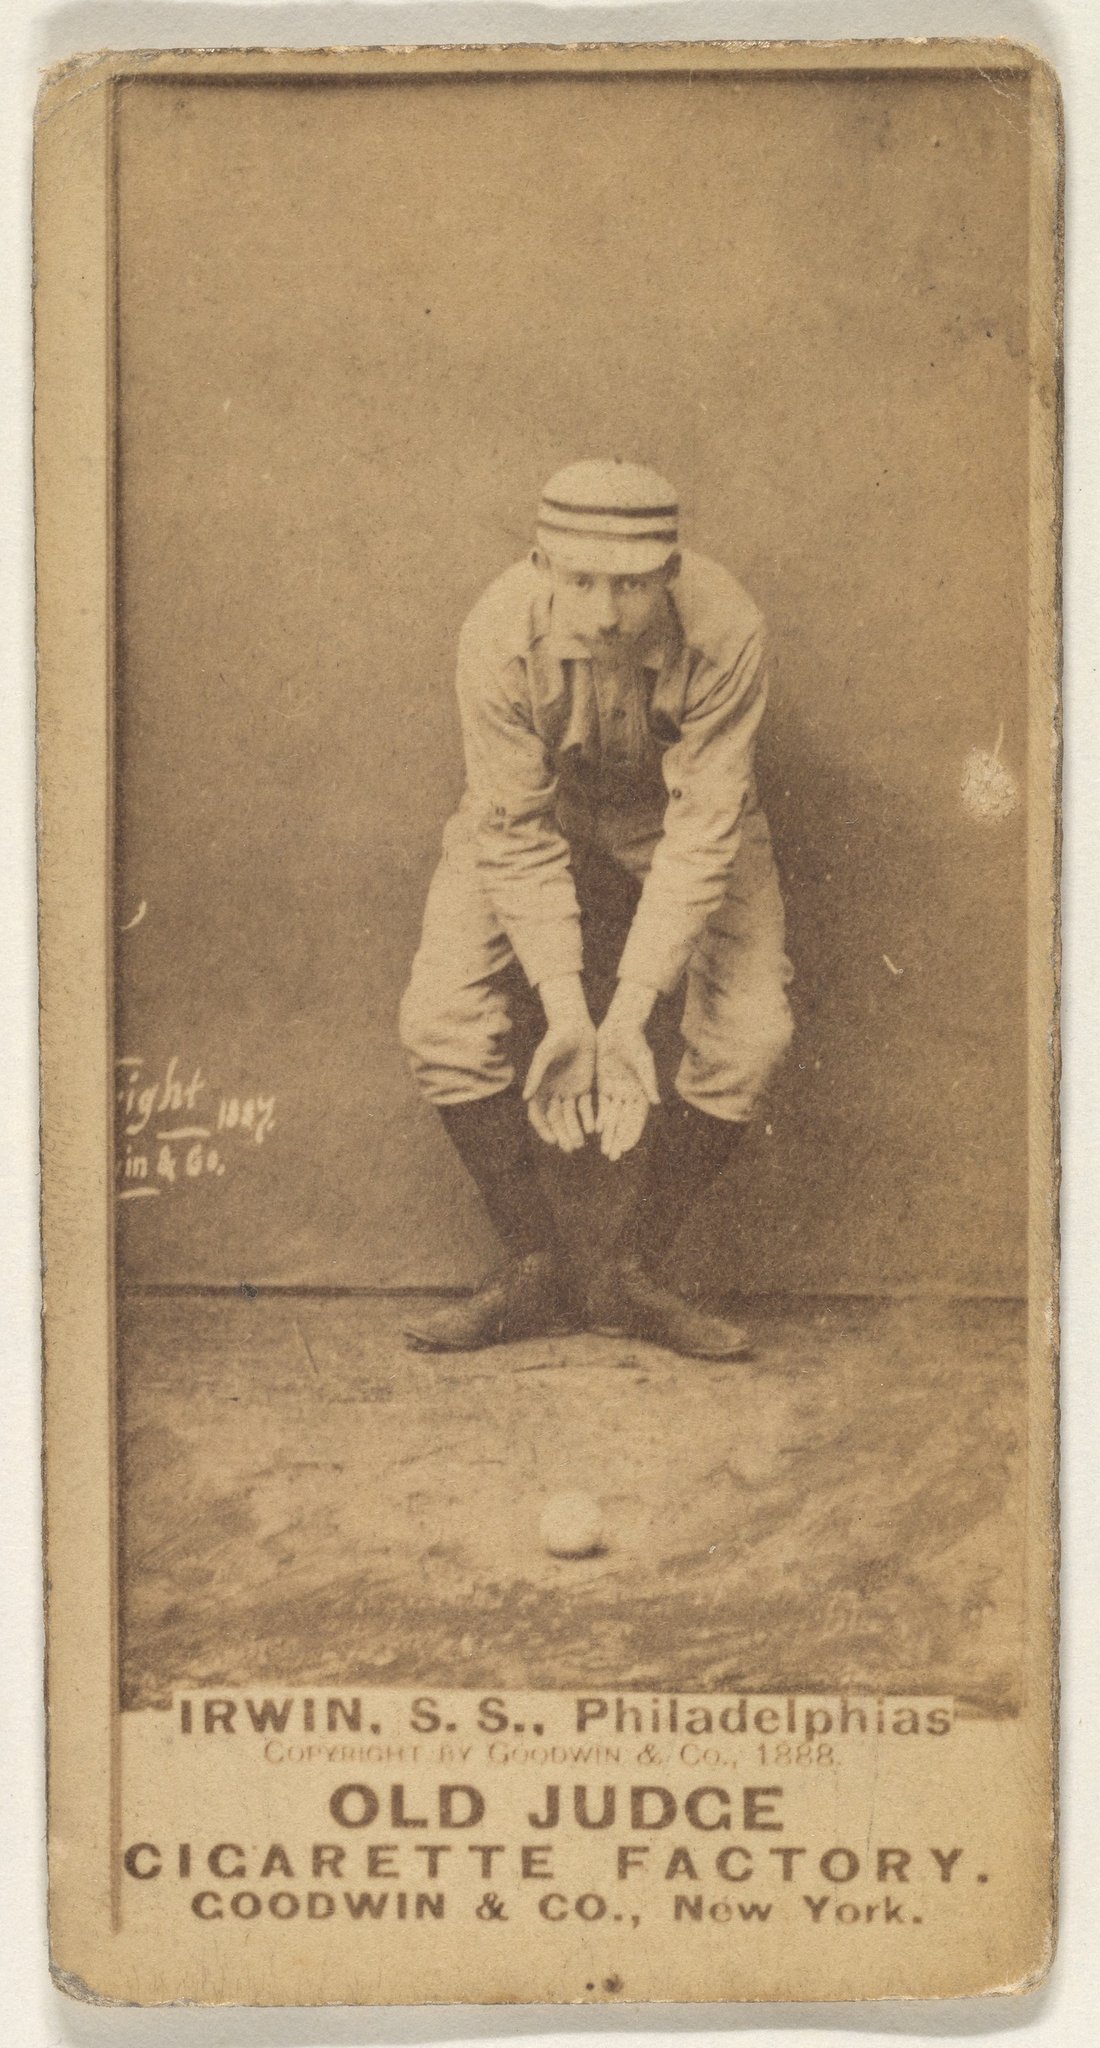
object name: baseball card, photograph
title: Arthur Albert "Doc" Irwin, Shortstop, Philadelphia, from the Old Judge series (N172) for Old Judge Cigarettes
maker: goodwin & company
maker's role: publisher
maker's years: 1850-1950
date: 1888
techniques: albumen silver print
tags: men,portraits,baseball,athletes